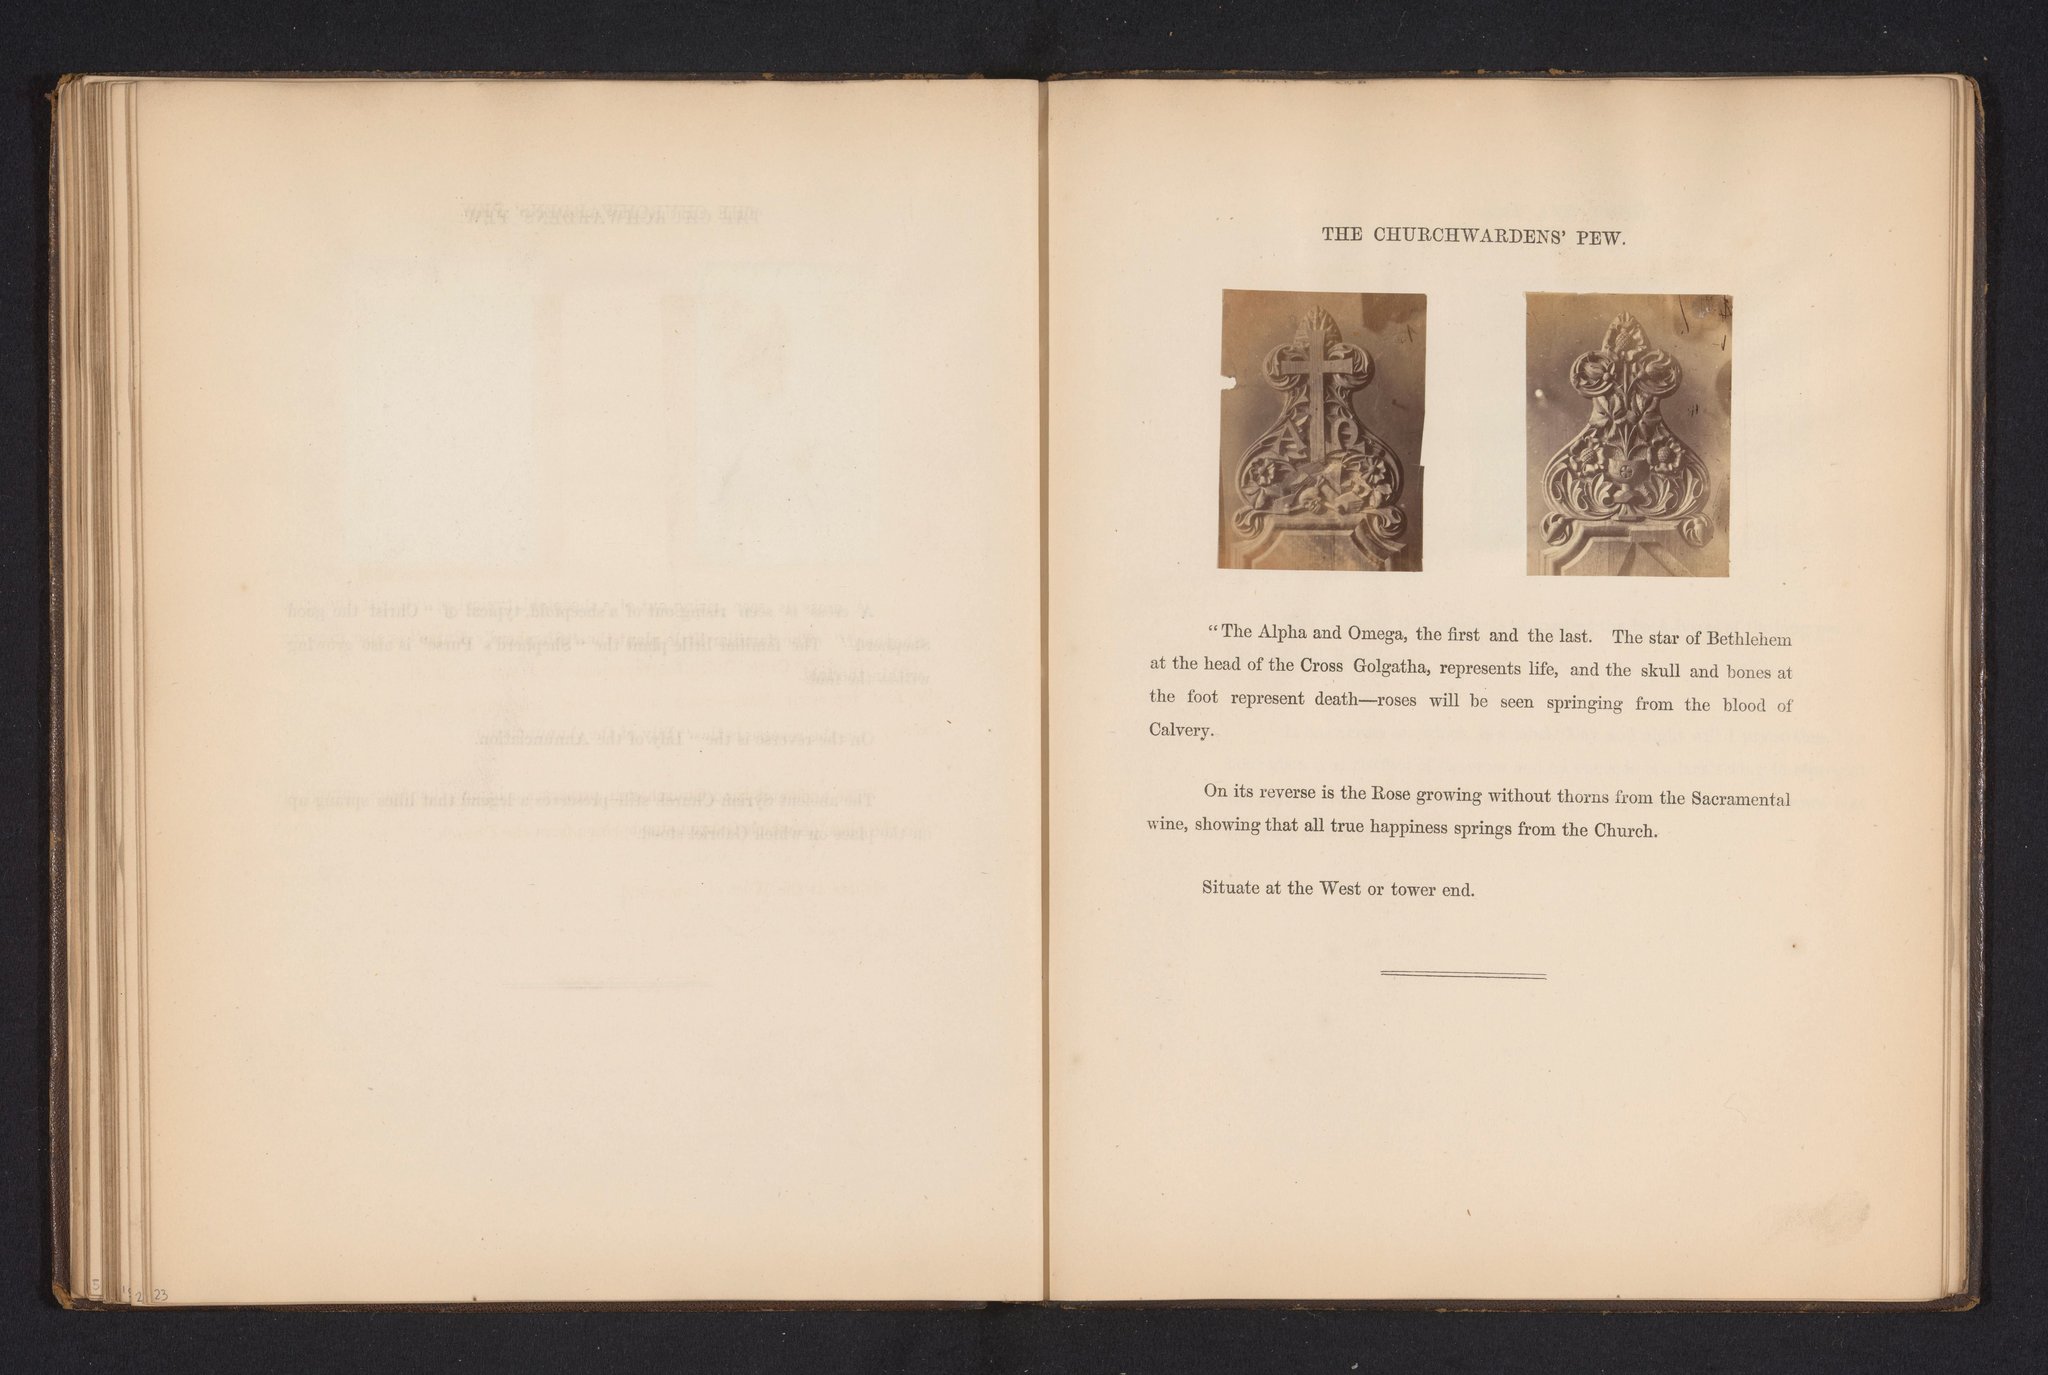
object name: page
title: The Churchwardens' pew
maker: Anonymous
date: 1857-1867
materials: photographic support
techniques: albumen print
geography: st michael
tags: bench, the eucharist ~ the fourth of the seven sacraments, the cross ~ symbols of christ, alpha and omega ~ symbol of god the father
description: Links: een kruis met de tekens voor Alfa en Omega, rechts: een eucharistiebeker waaruit een roos zonder doornen.